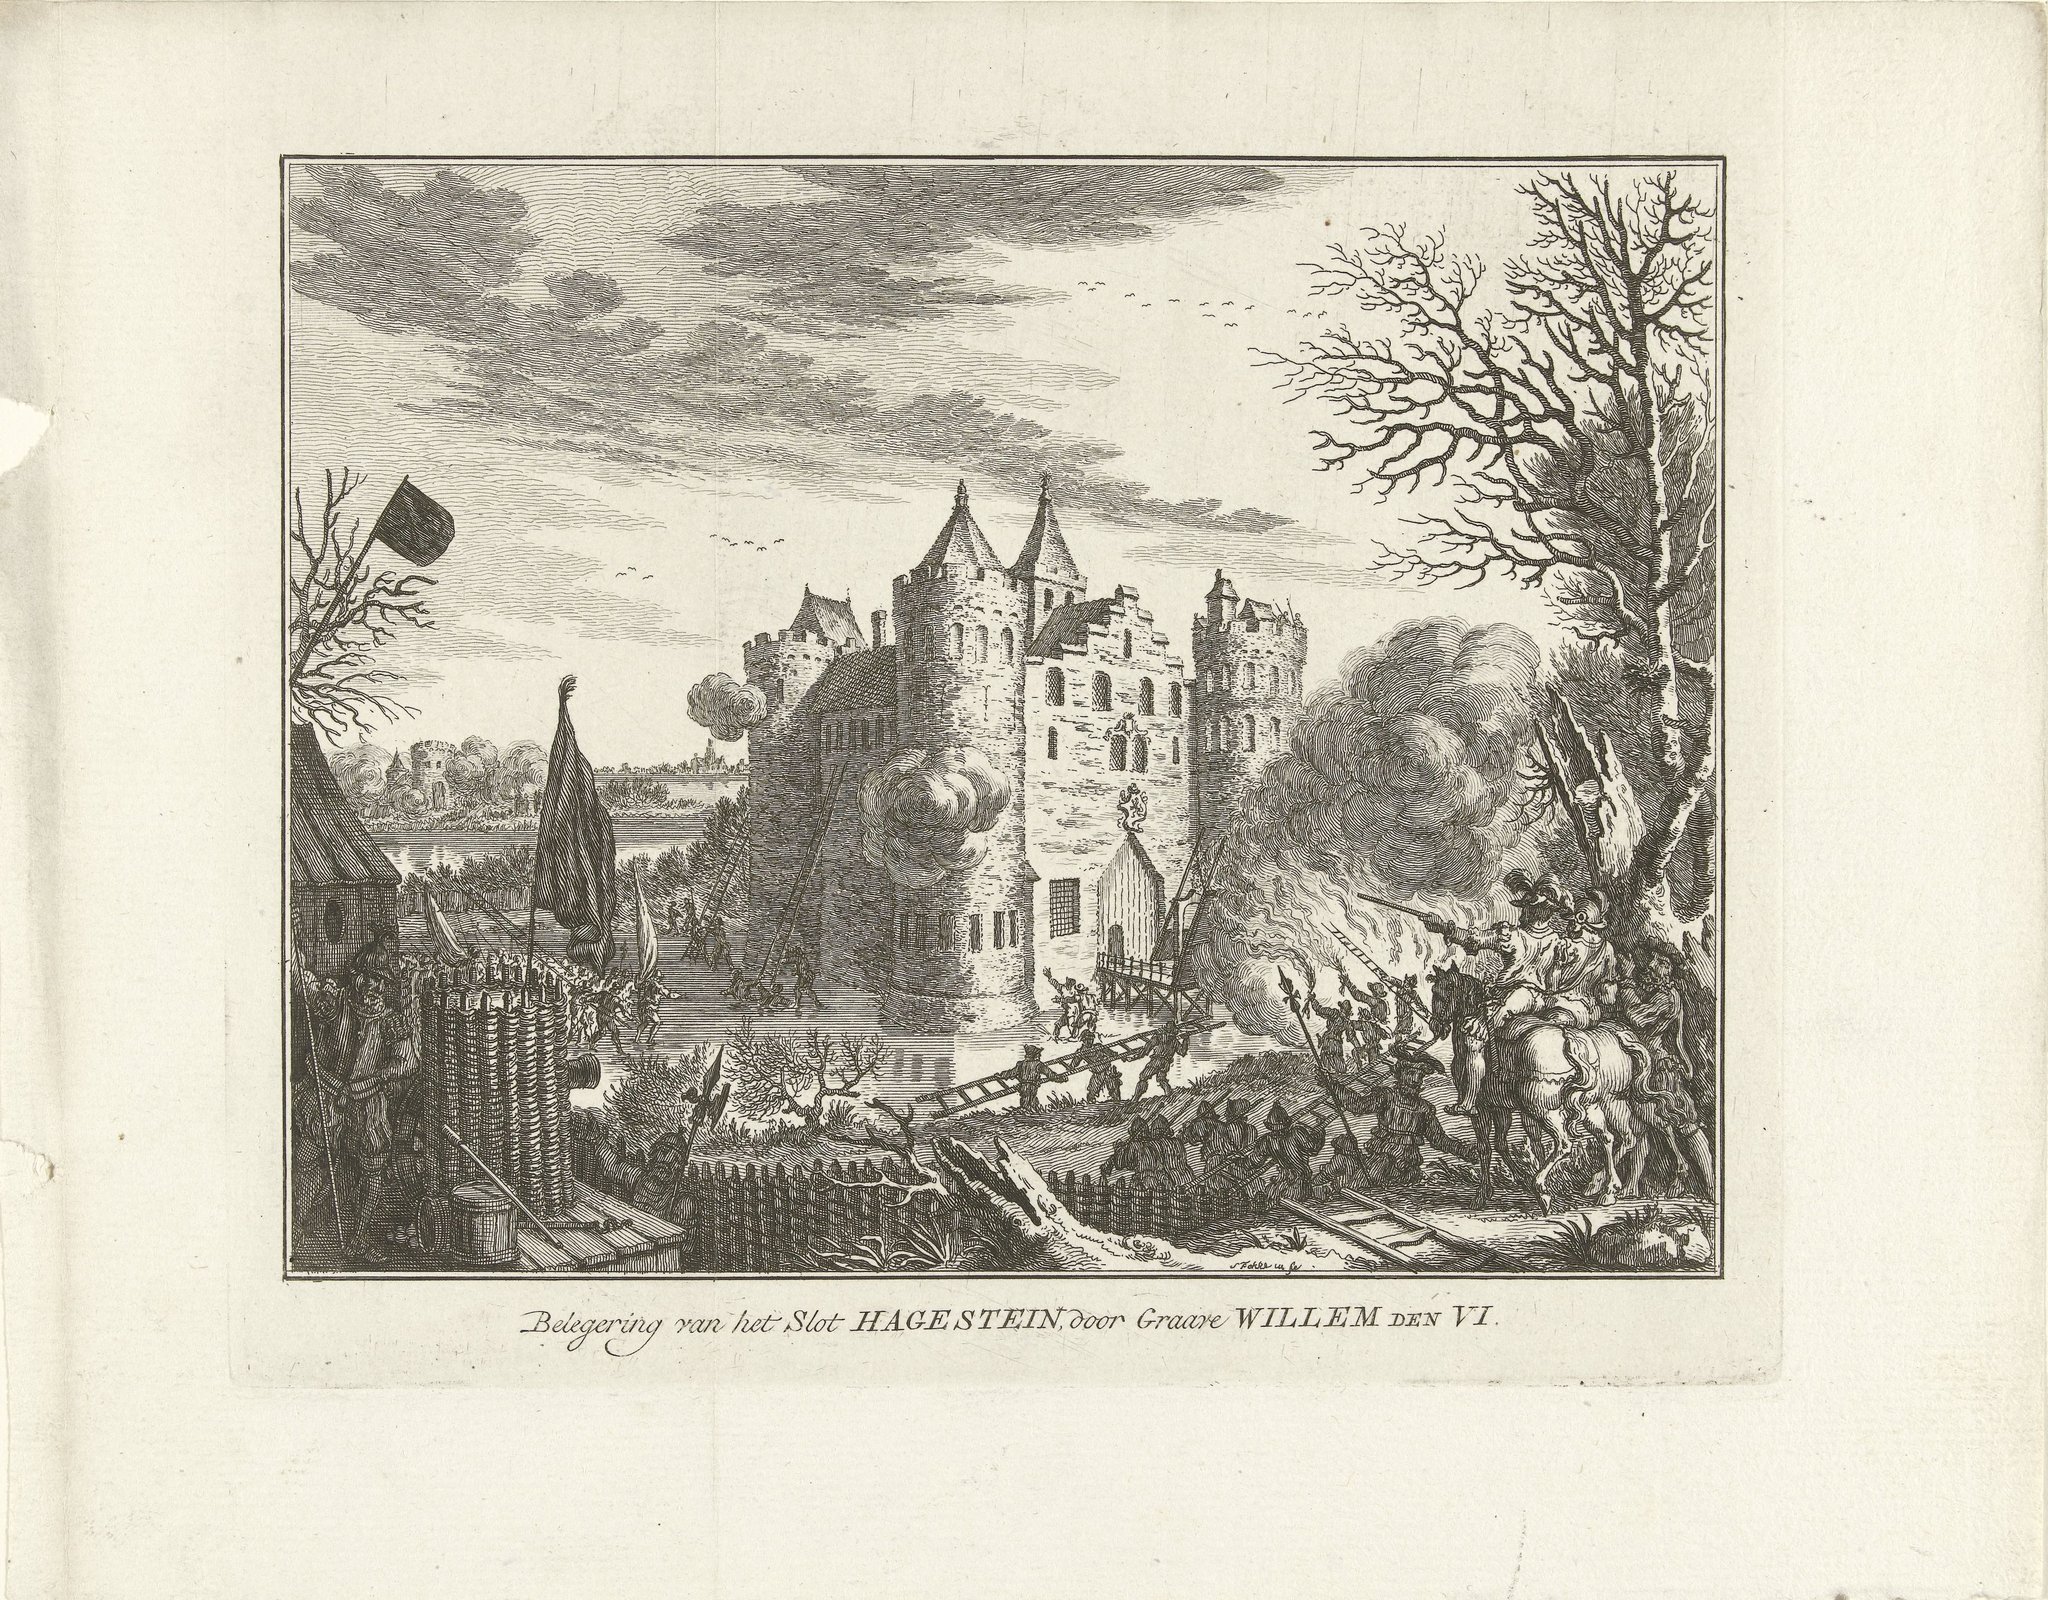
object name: print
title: Belegering van het Slot Hagestein, door Graave Willem den VI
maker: simon fokke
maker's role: draughtsman, print maker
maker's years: 1712-1784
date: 1750-1783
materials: paper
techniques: etching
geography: amsterdam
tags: holland en zeeland willem vi van henegouwen, siege, position war, hagestein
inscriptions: collector's mark: Lugt 2228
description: Gebruikt als illustratie in de eerste en tweede druk van: Wagenaar, Jan. Vaderlandsche historie, 21 delen. Amsterdam: I. Tirion e.a., 1750-1783, dl. III.